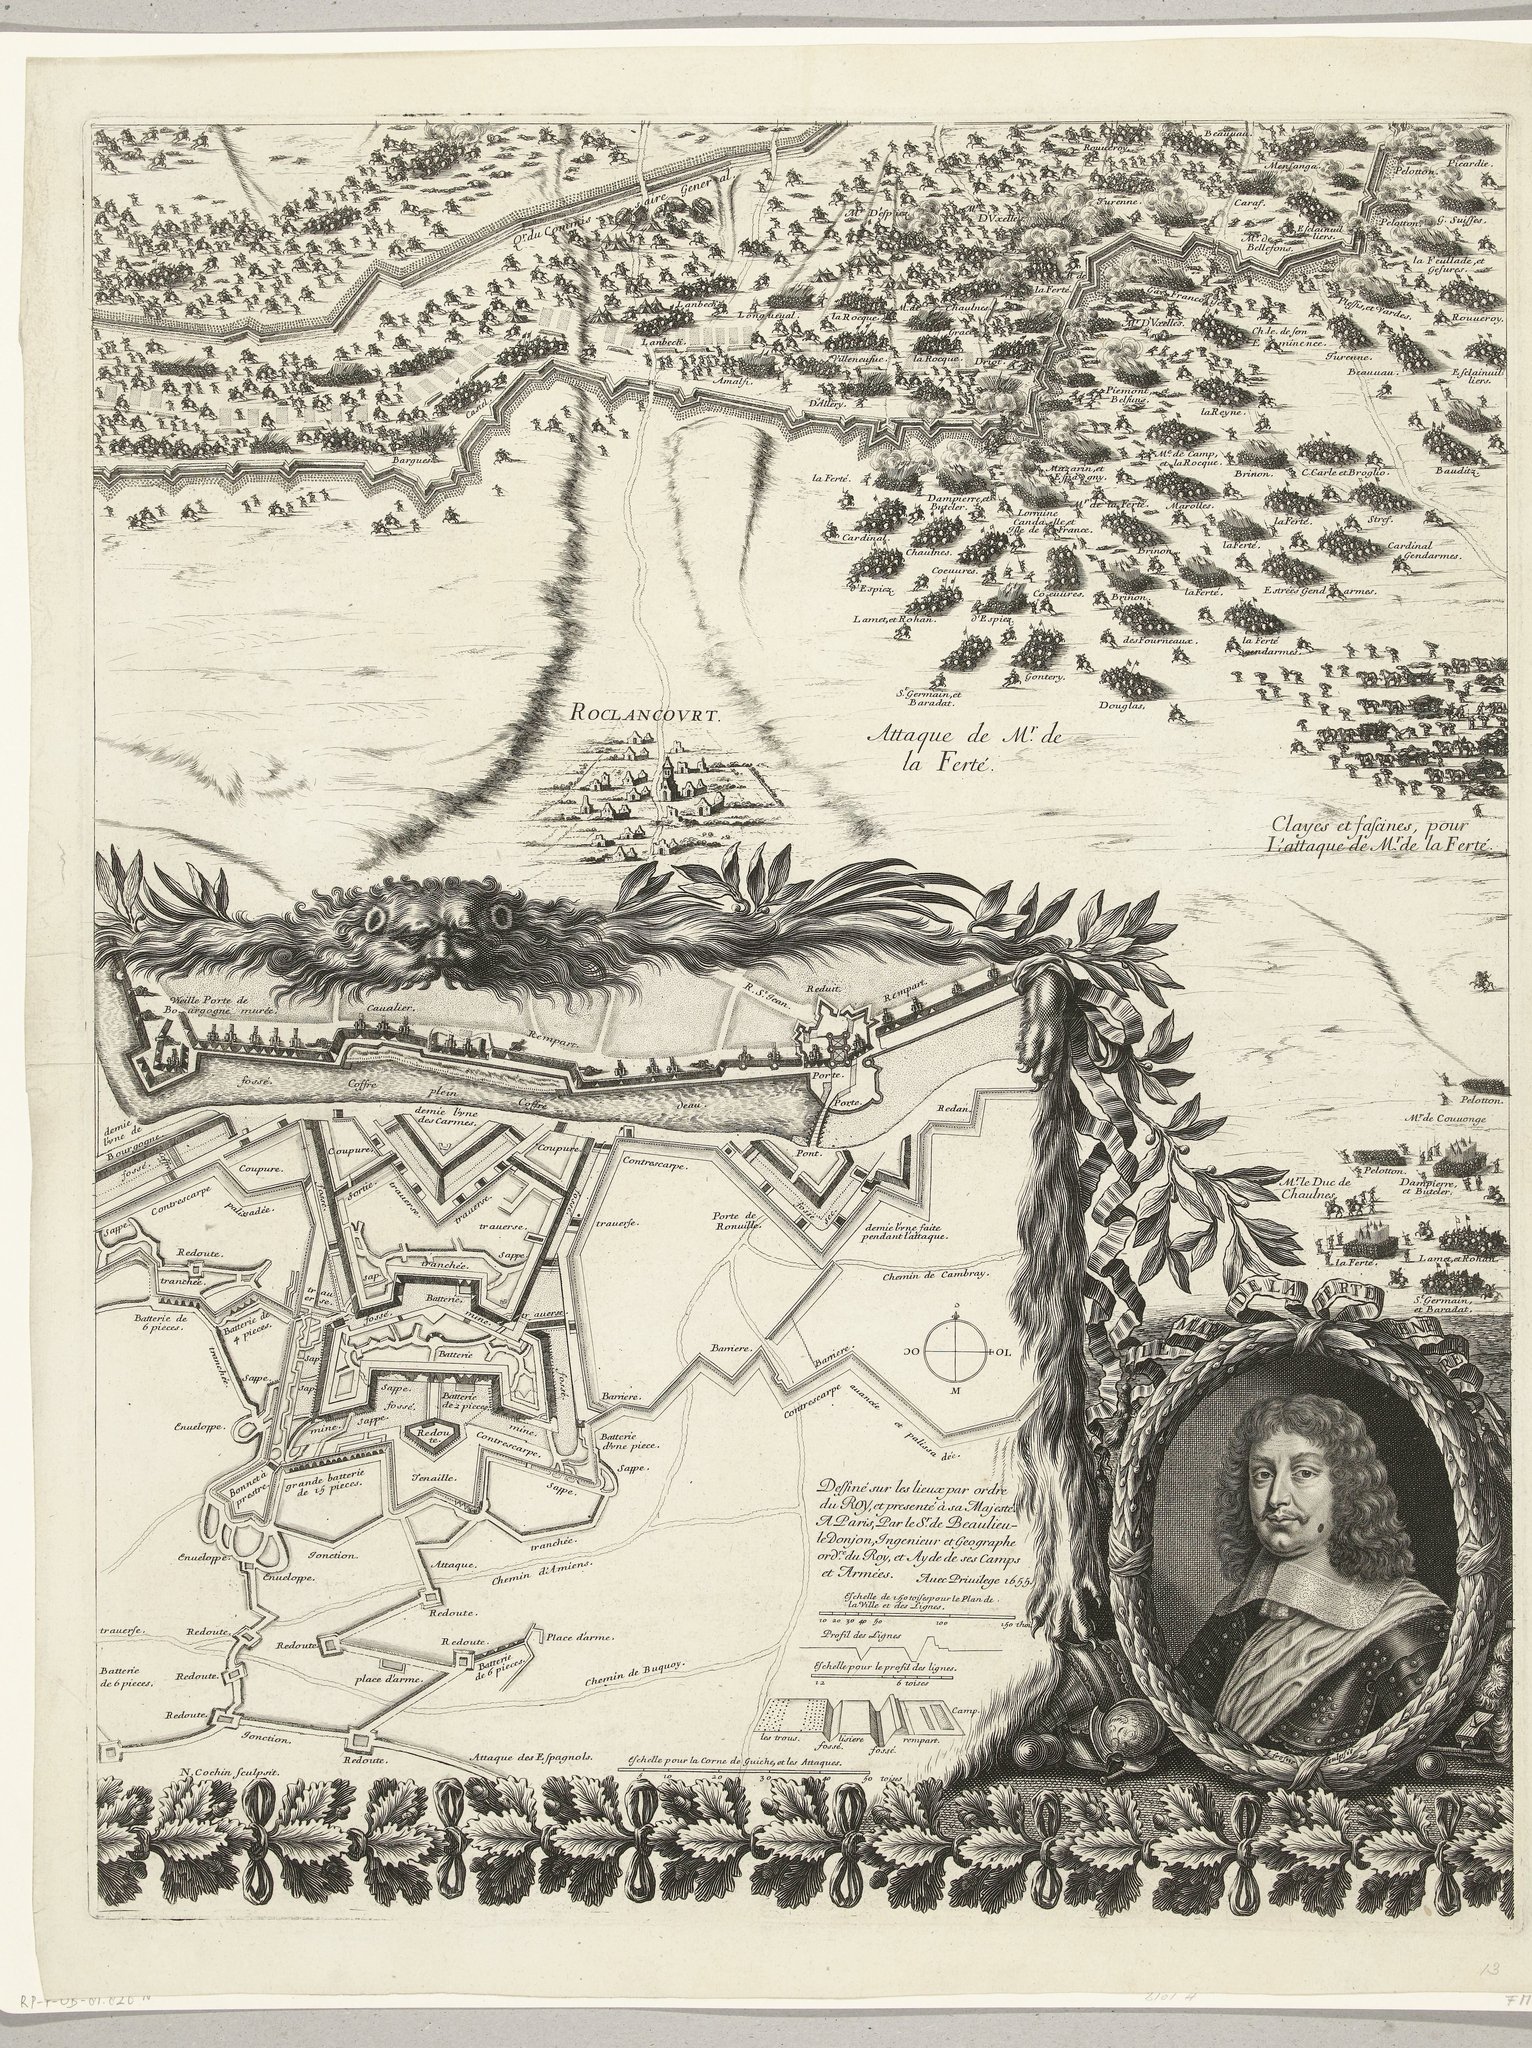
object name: propagandaprent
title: Le siege d'Arras leve par la defaite des ennemis 1654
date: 1655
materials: paper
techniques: engraving, etching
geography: france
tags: vienna, leopold willem van oostenrijk (landvoogd der zuidelijke nederlanden), raising the siege with outside assistance, relief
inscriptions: date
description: Ontzet van de stad Arras (Atrecht), belegerd door de Spanjaarden, 23-25 augustus 1654. Arras ontzet door het Franse leger onder de maarschalk Turenne van het beleg door de Spanjaarden onder Louis de Condé en aartshertog Leopold Willem. Derde blad in de onderste rij. Deel van de kaart met de aanvallende Franse troepen, onderaan een deel van een inzet met een detailvoorstelling van de verdedigingswerken van de stad en een portret van maarschalk de La Ferté-Senneterre. Onderdeel van een ongemonteerd geheel bestaande uit een titelblad en een grote voorstelling op vijftien platen (de halve plaat rechtsonder ontbreekt).